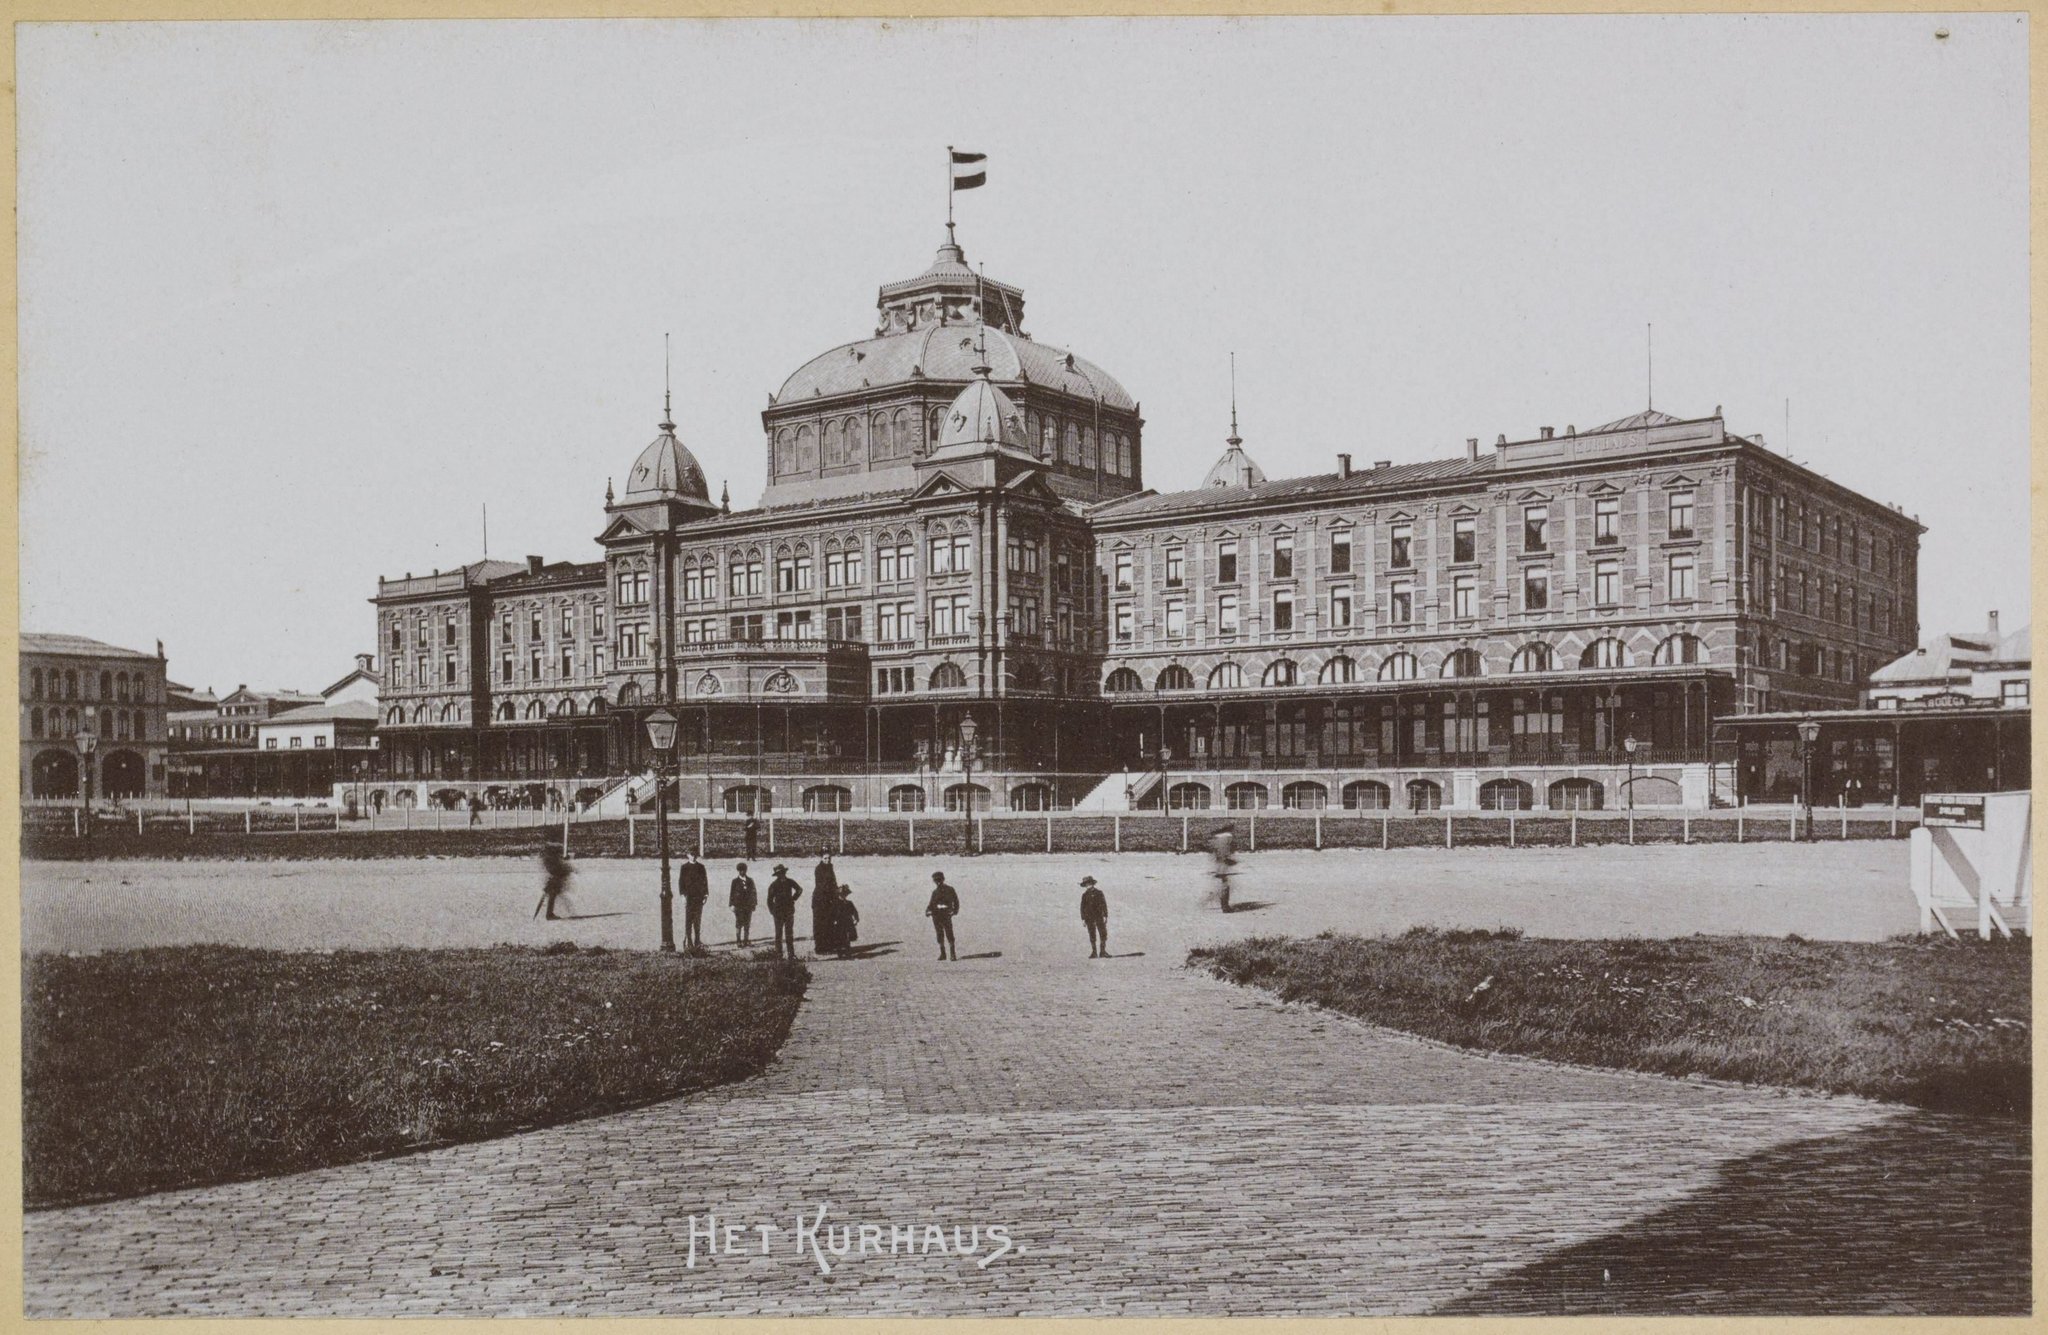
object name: photograph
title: Gezicht op het Kurhaus in Scheveningen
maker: Anonymous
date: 1890-1910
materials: cardboard, paper, ink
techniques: photograph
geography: scheveningen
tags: watering-place, spa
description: Onderdeel van Leporelloalbum met opnames van Scheveningen.